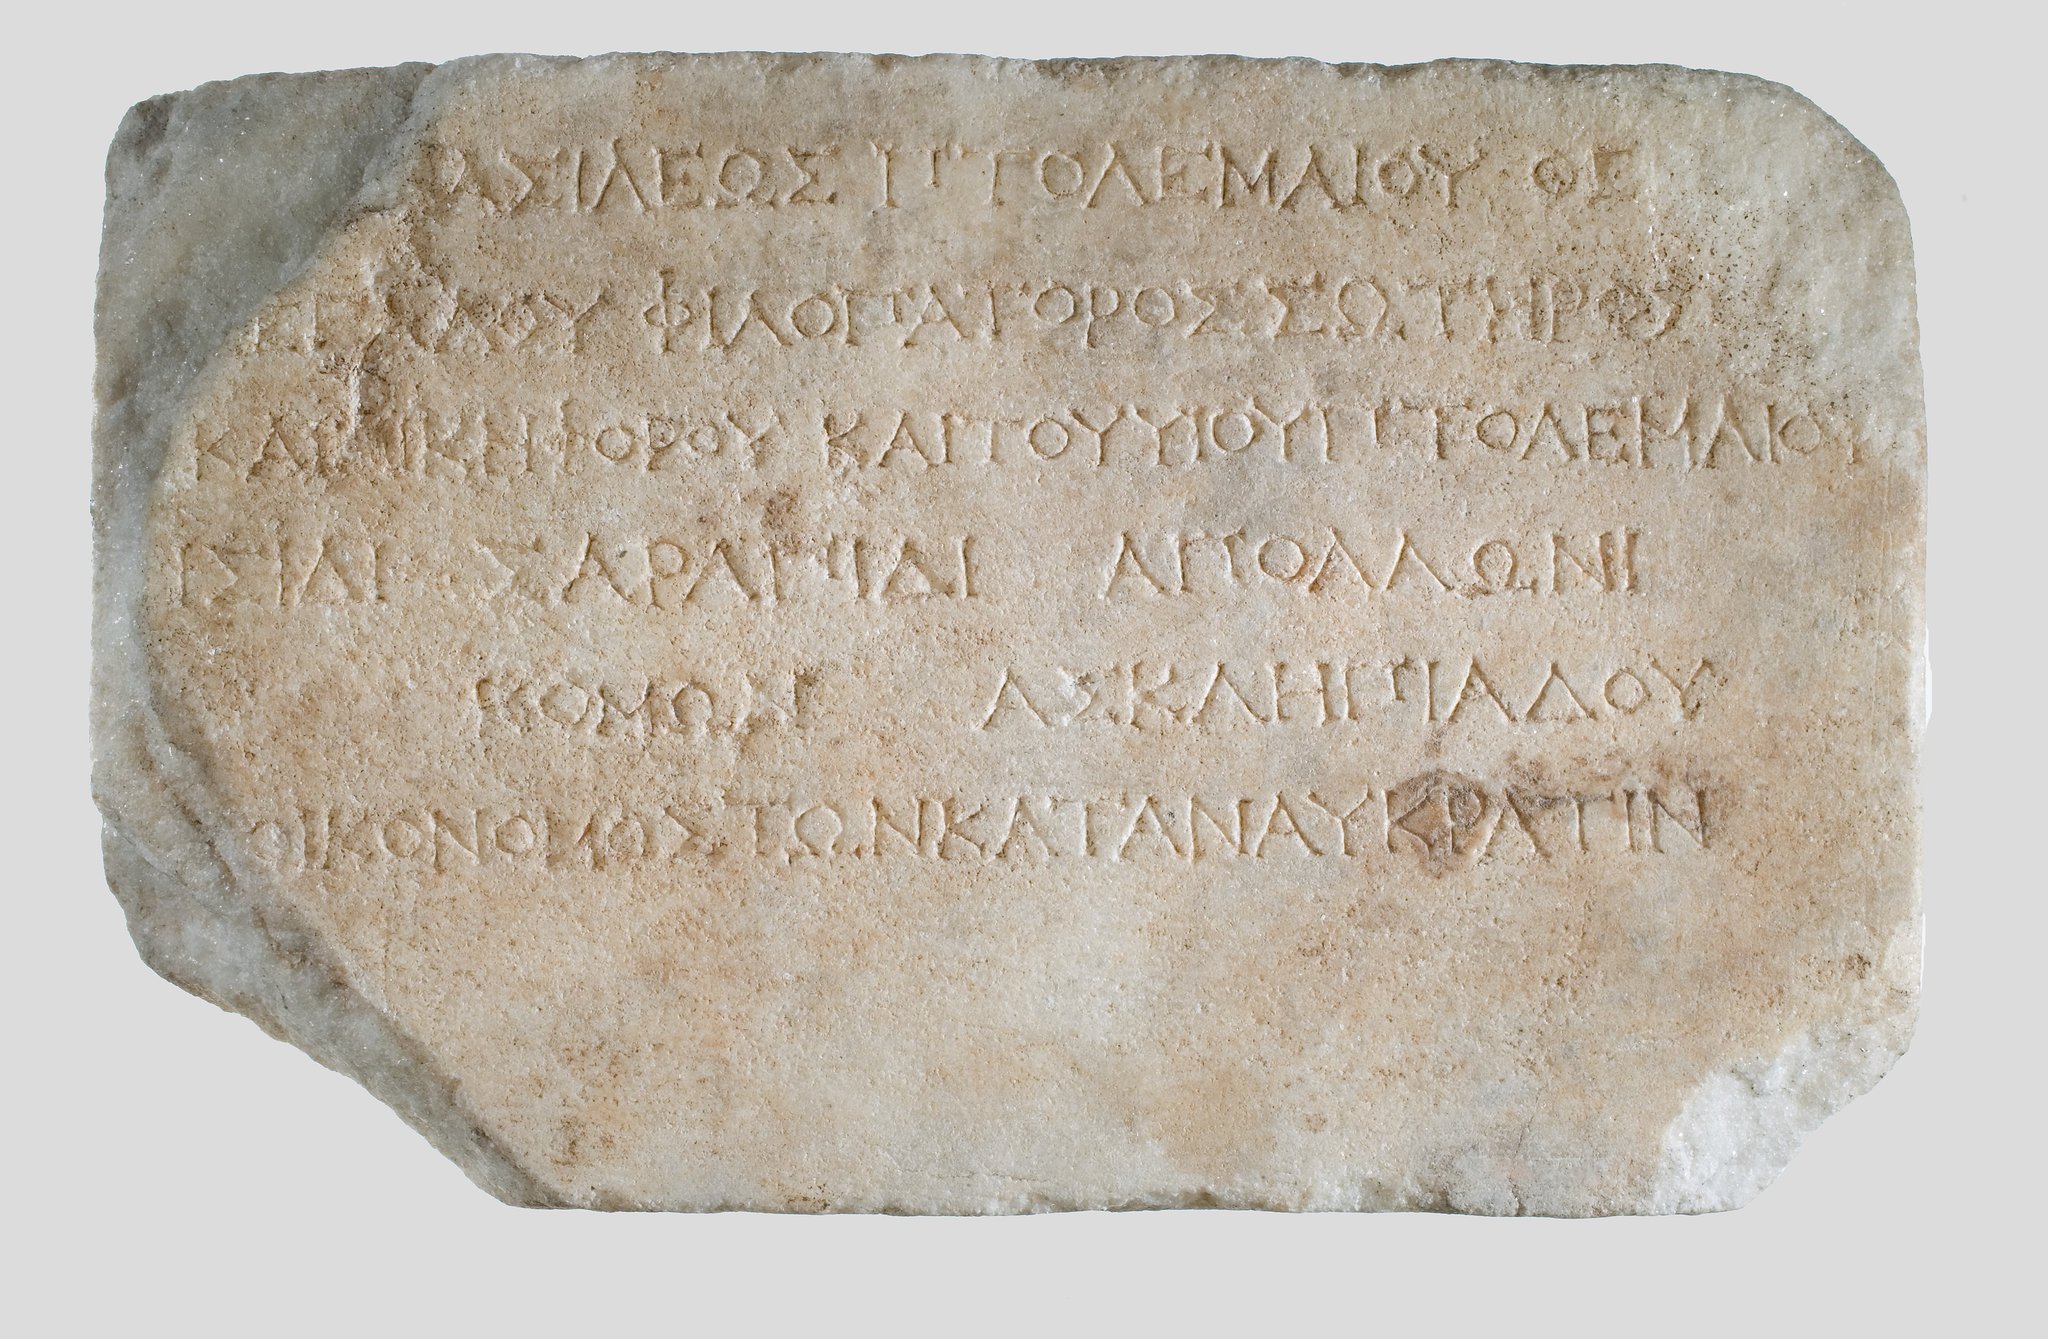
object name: plaque, greek, isi, serapis, apollo, komon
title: Plaque with Greek dedication to Isis, Serapis and Apollo by Komon for the benefit of Ptolemy IV and V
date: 210-204 BCE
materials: marble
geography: egypt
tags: greek